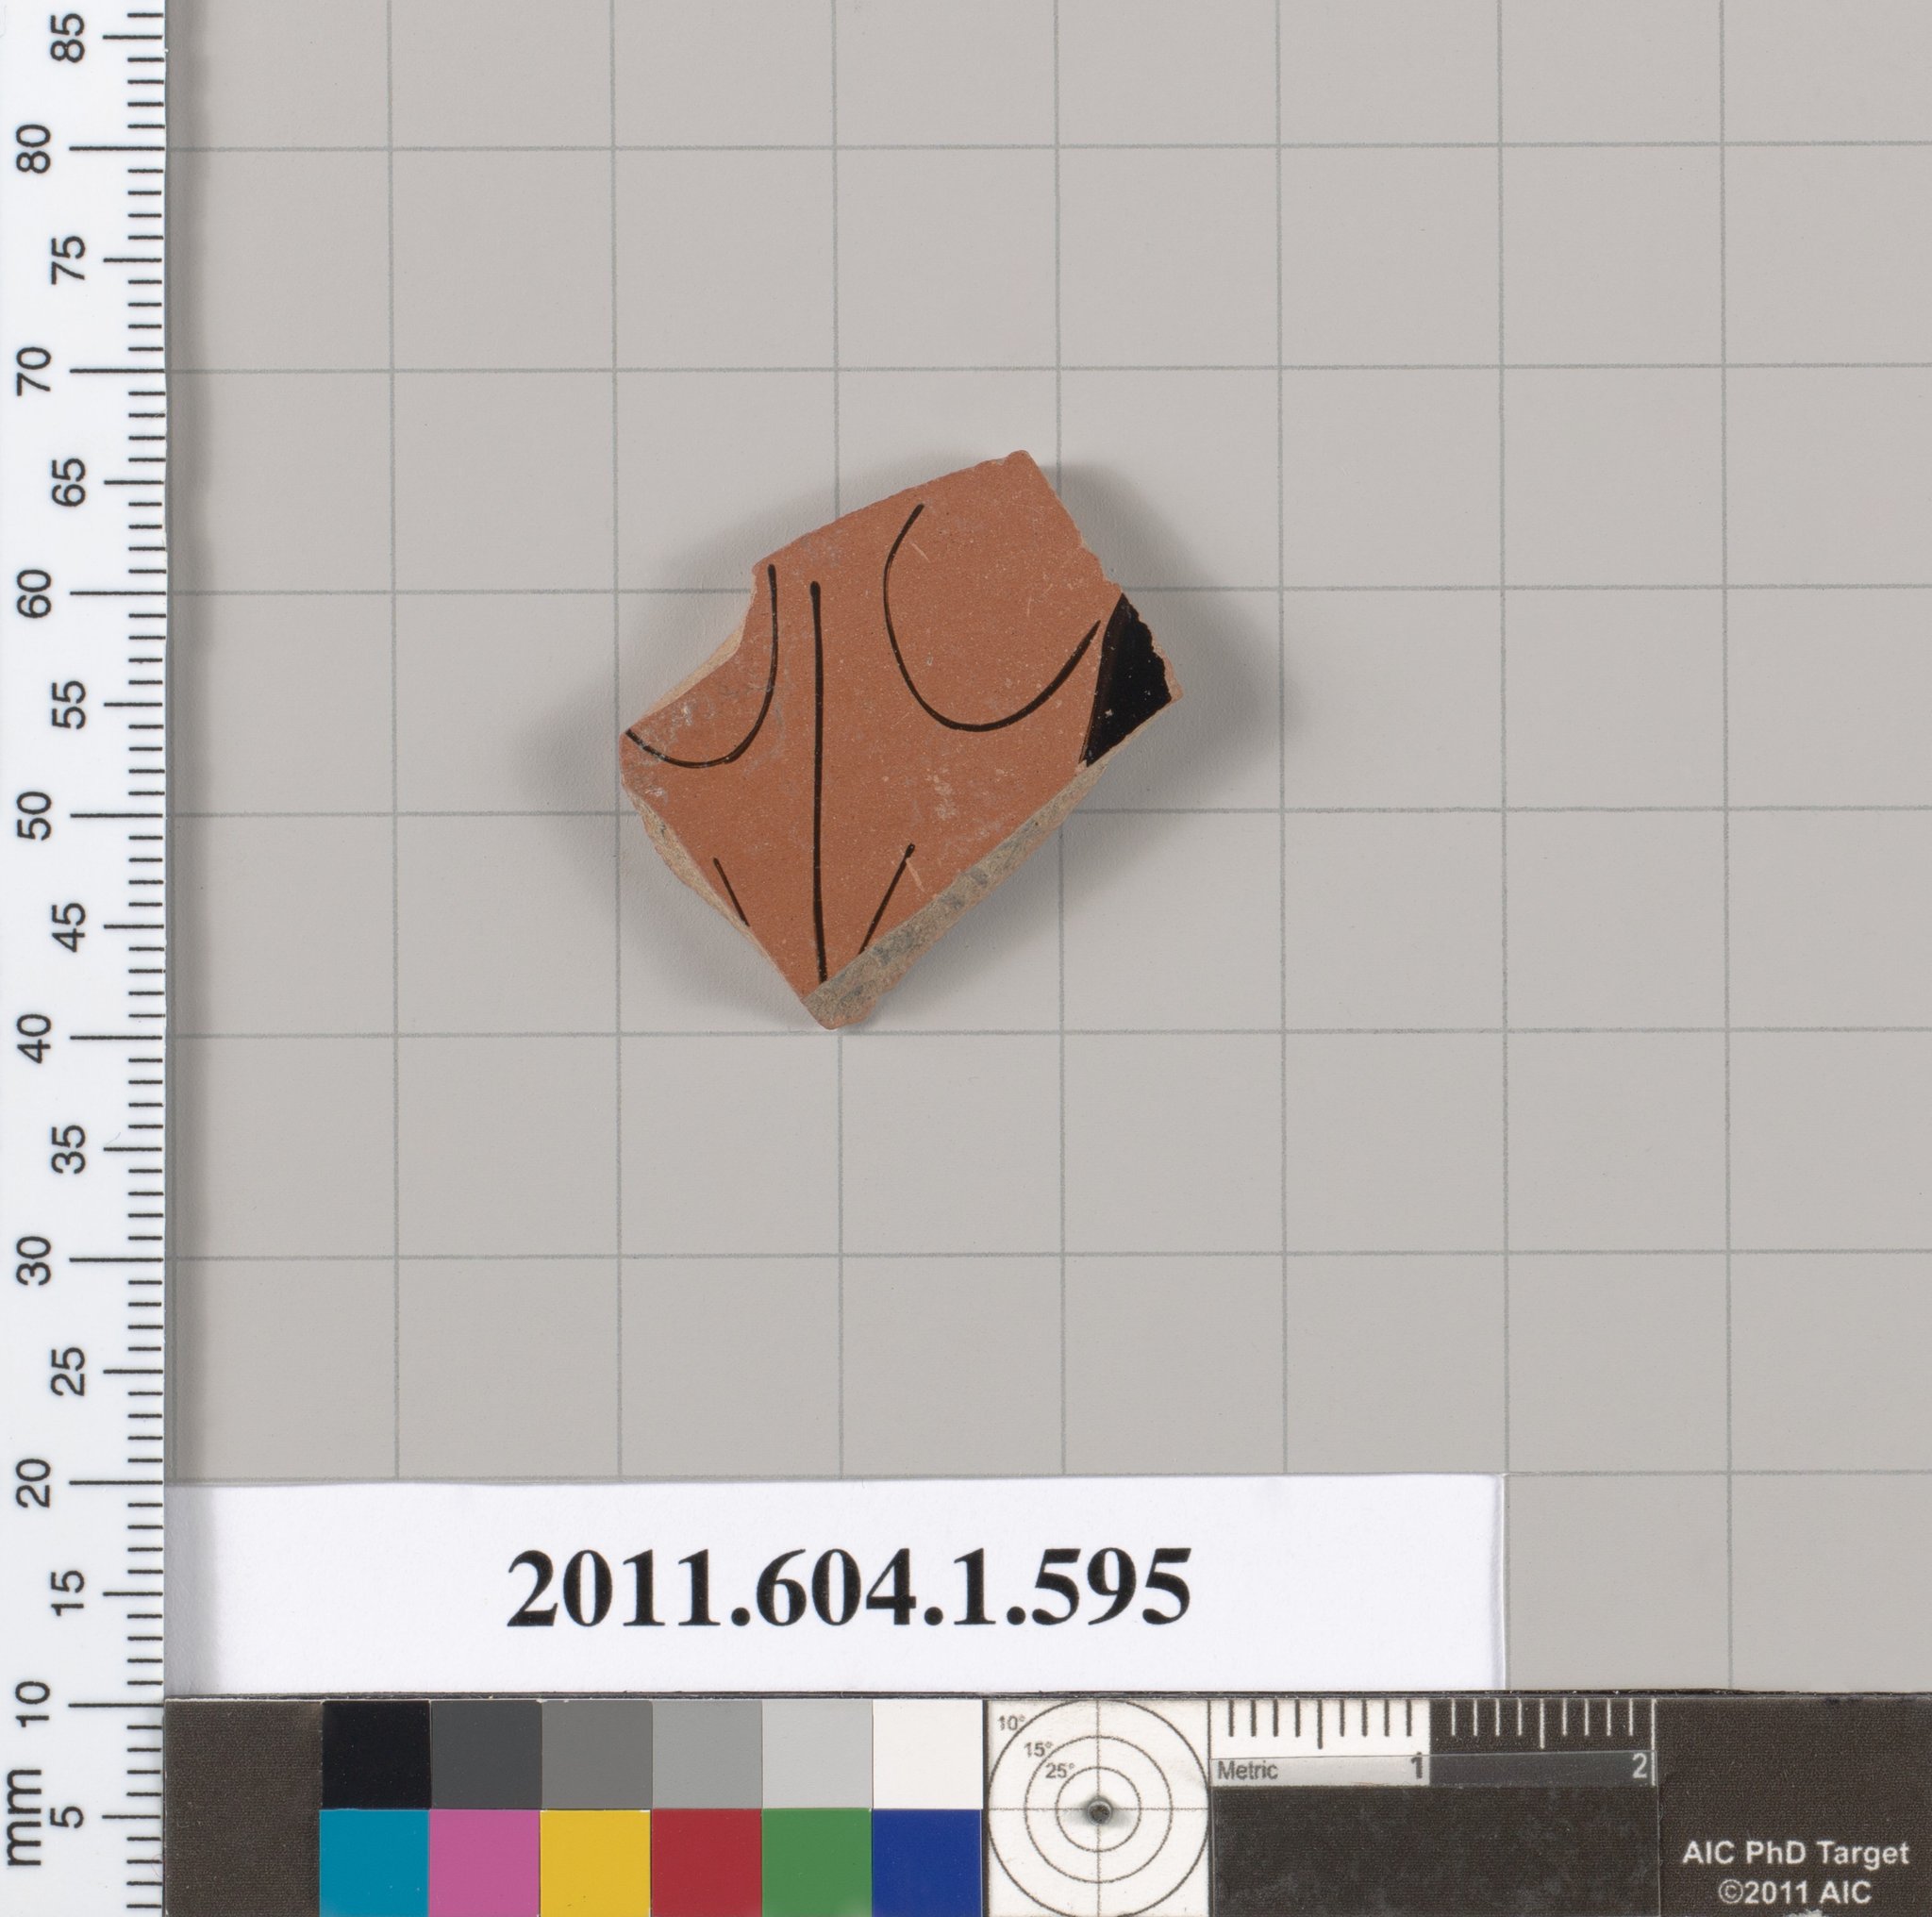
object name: kylix fragment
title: Terracotta fragment of a kylix (drinking cup)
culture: greek, attic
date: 475-451 BCE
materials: terracotta